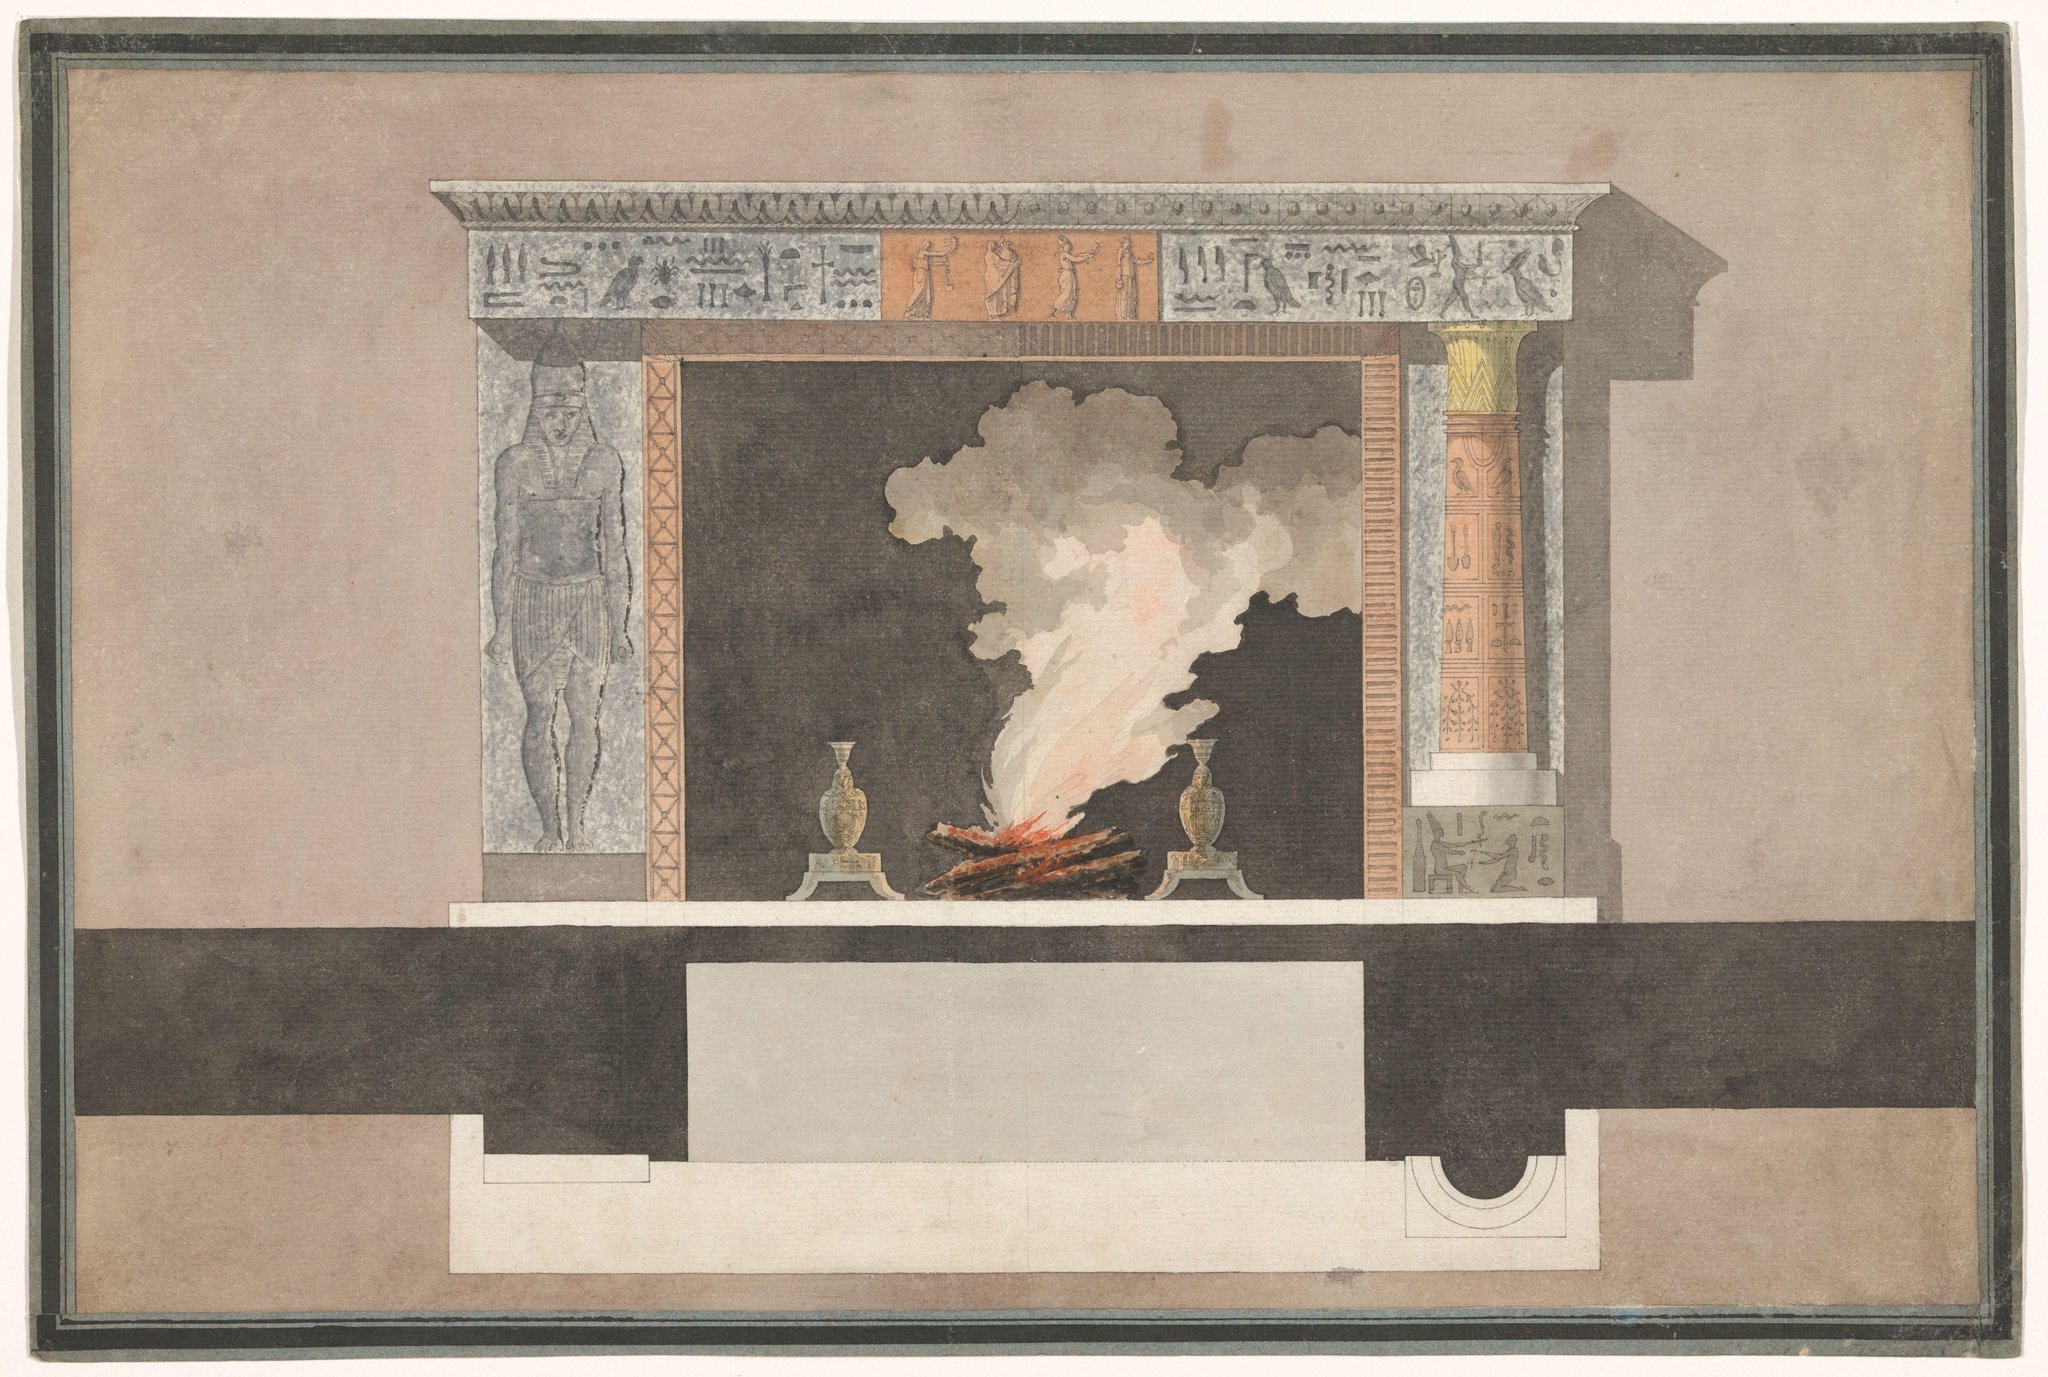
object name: drawing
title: Ontwerp voor schoorsteen in Egyptische stijl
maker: jean démosthène dugourc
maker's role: draughtsman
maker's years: 1749-1825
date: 1790-1800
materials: graphite, paper, watercolor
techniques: brush, pen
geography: paris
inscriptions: watermark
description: Ontwerp voor een schoorsteen in Egyptische stijl, met twee alternatieve helften en daaronder een plattegrond